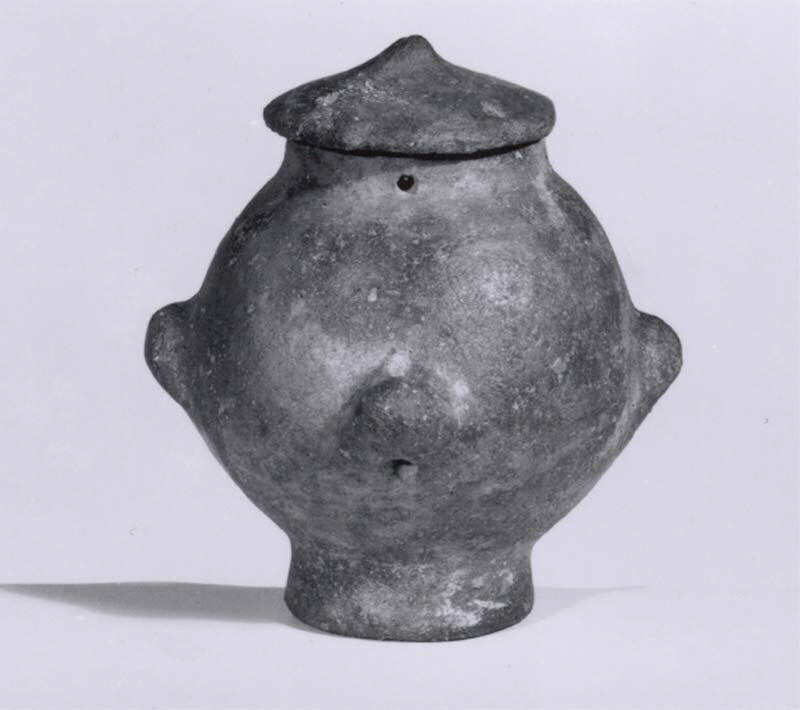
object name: vessel with lid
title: Vessel and lid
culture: yortan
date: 2700-2400 BCE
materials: ceramic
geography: northwestern anatolia